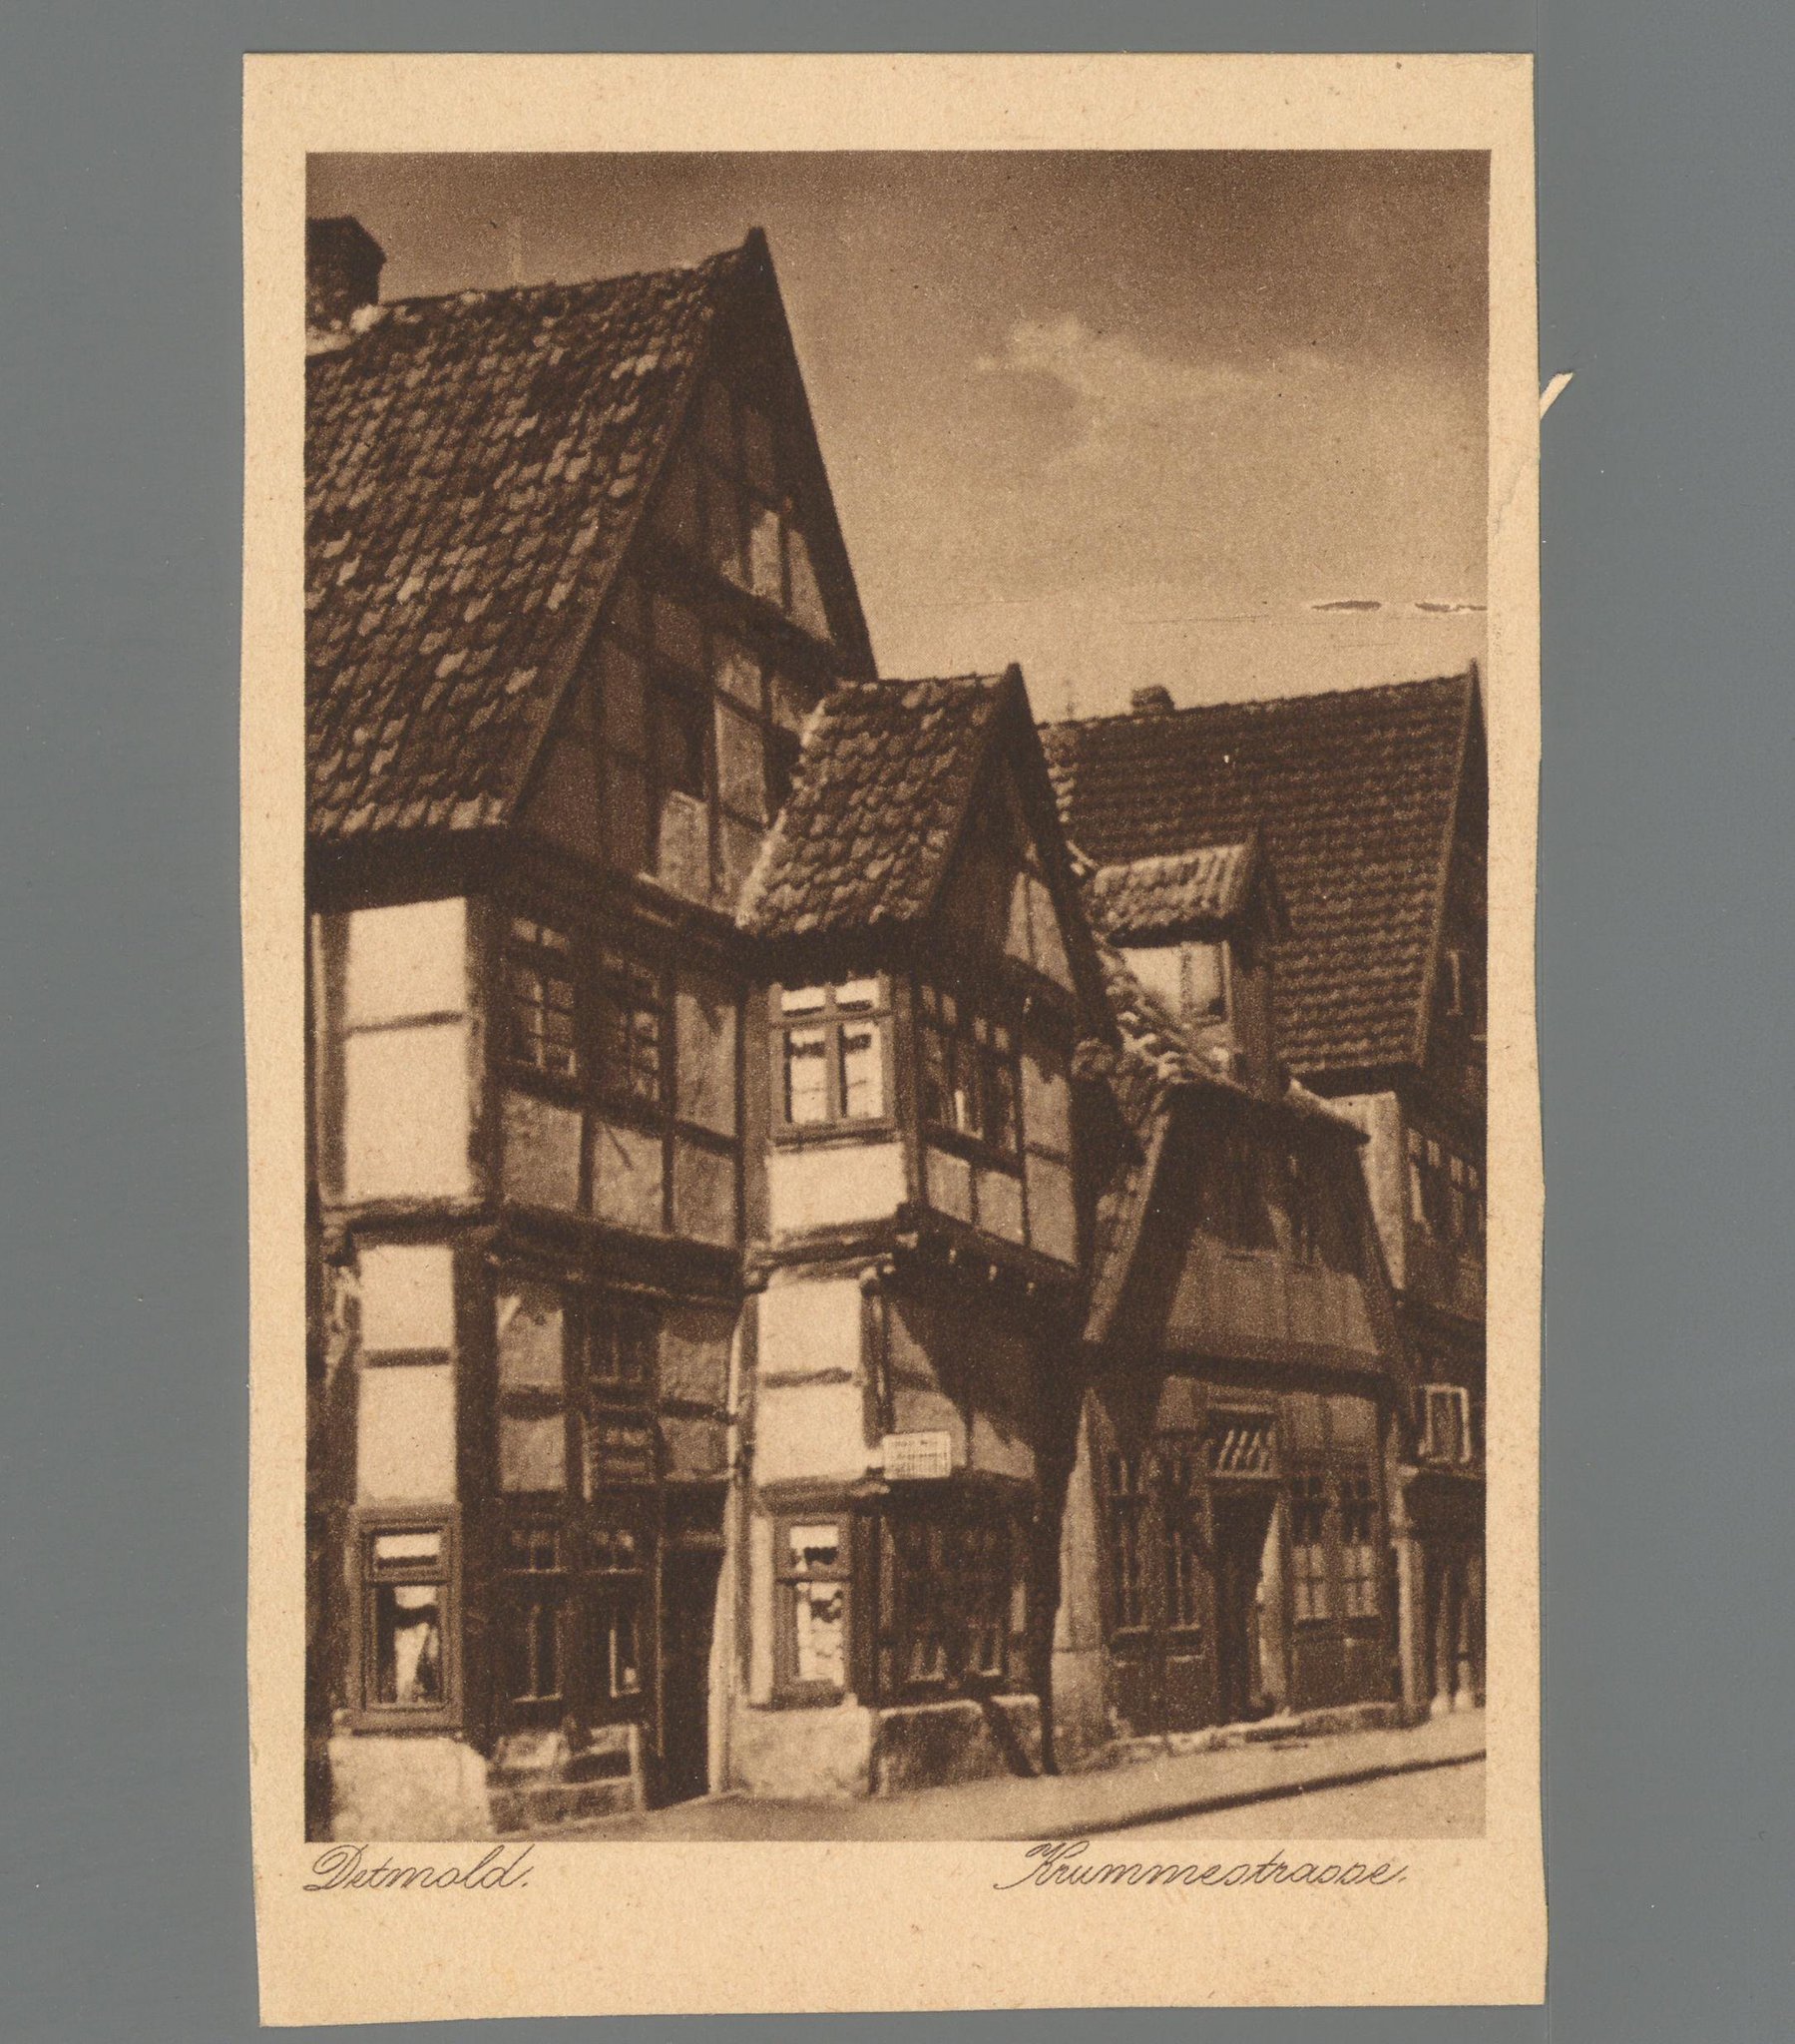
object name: photomechanical print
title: Detmold. Krummestrasse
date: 1905-1930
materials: cardboard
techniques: rotogravure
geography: detmold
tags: street